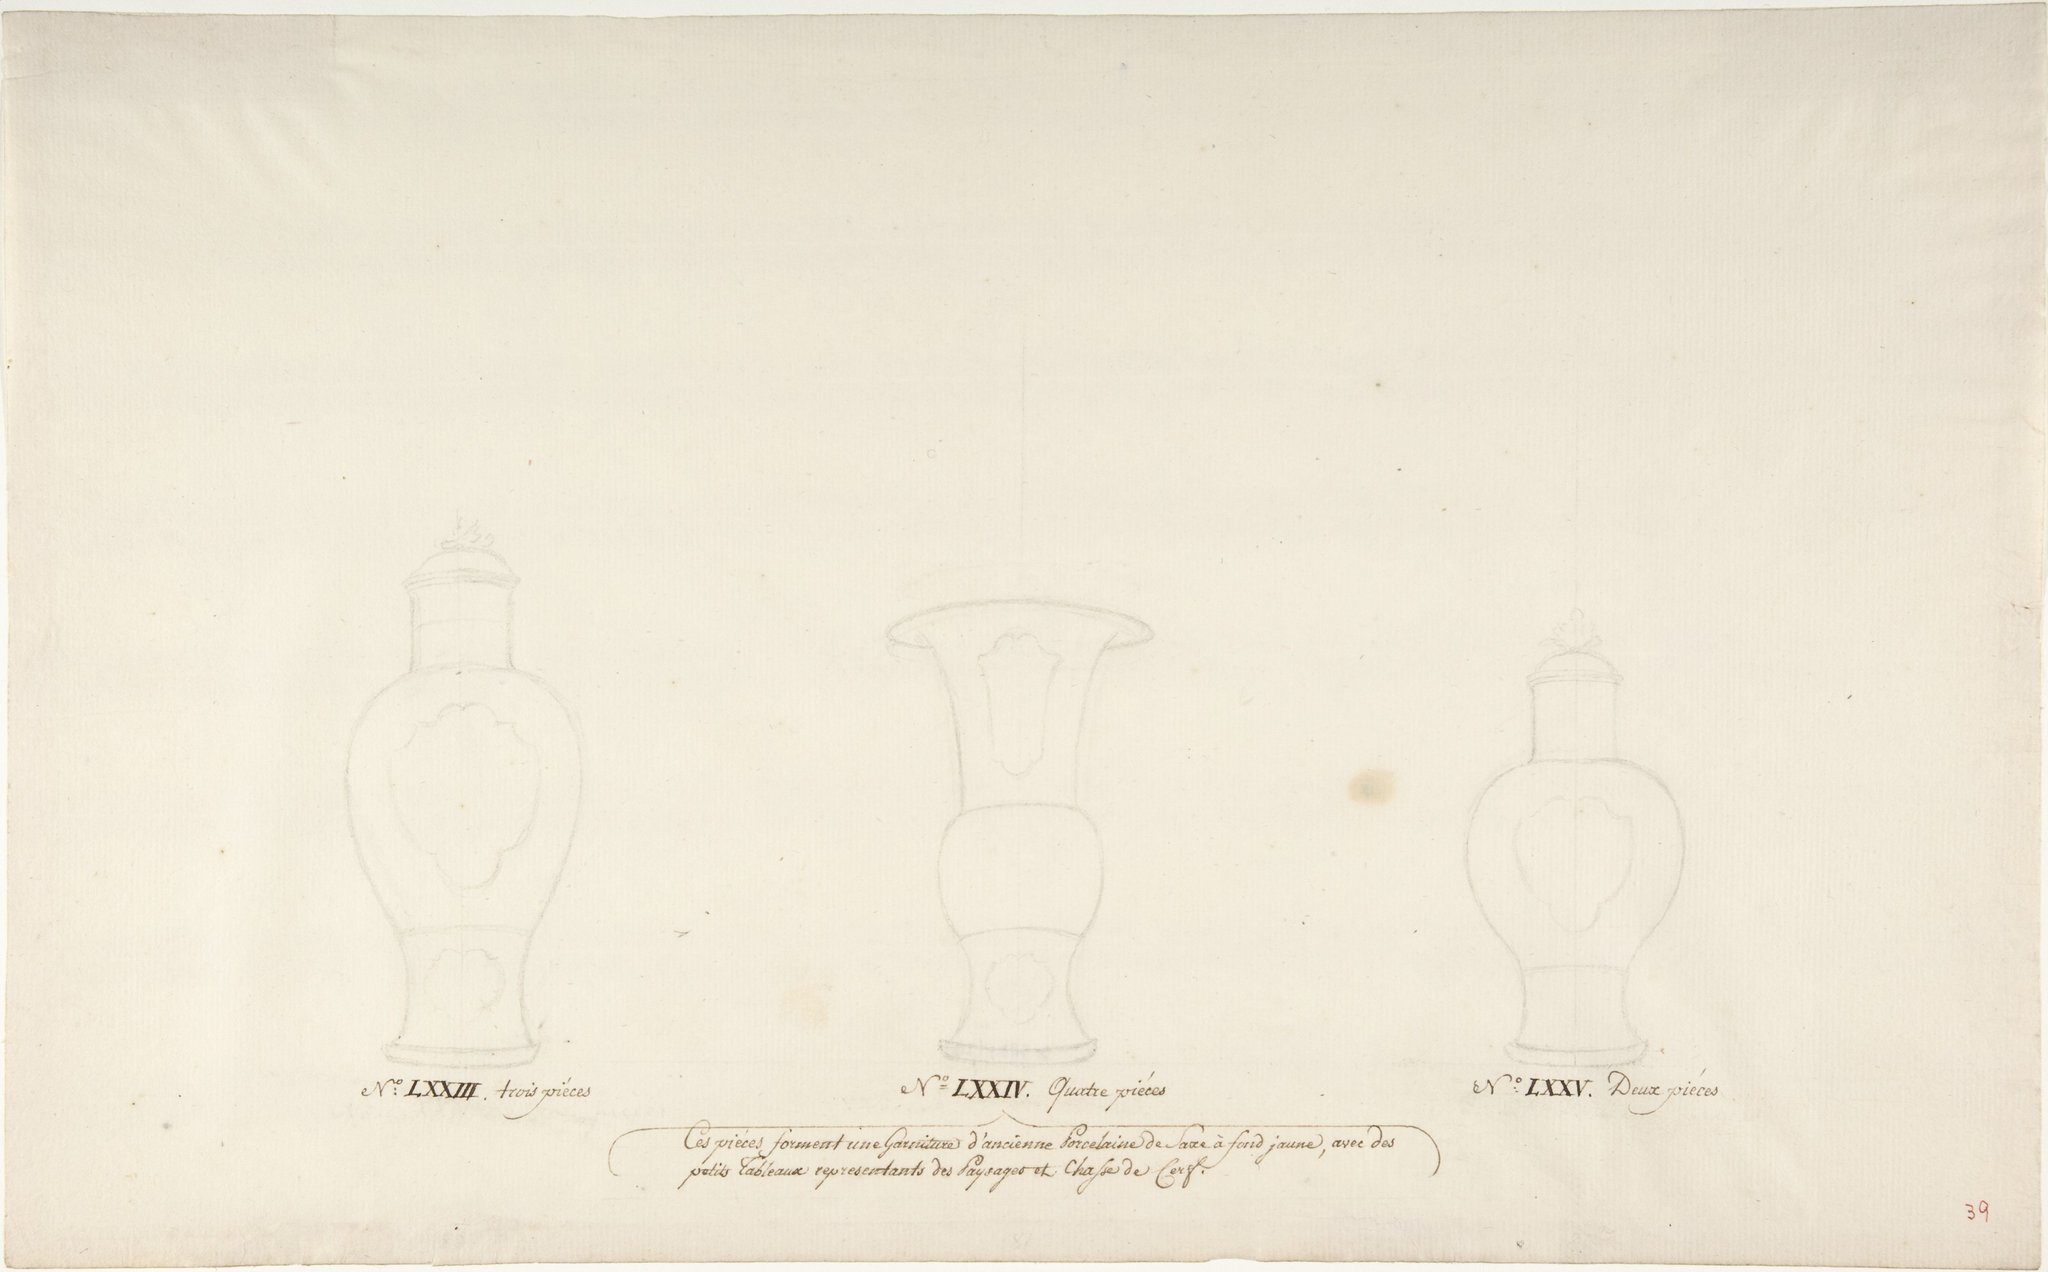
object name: drawing ornament architecture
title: Design for Three Vases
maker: anonymous, french, 18th century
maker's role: artist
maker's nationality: french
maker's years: 1700-1800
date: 1770-1785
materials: chalk, ink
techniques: pen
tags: vases